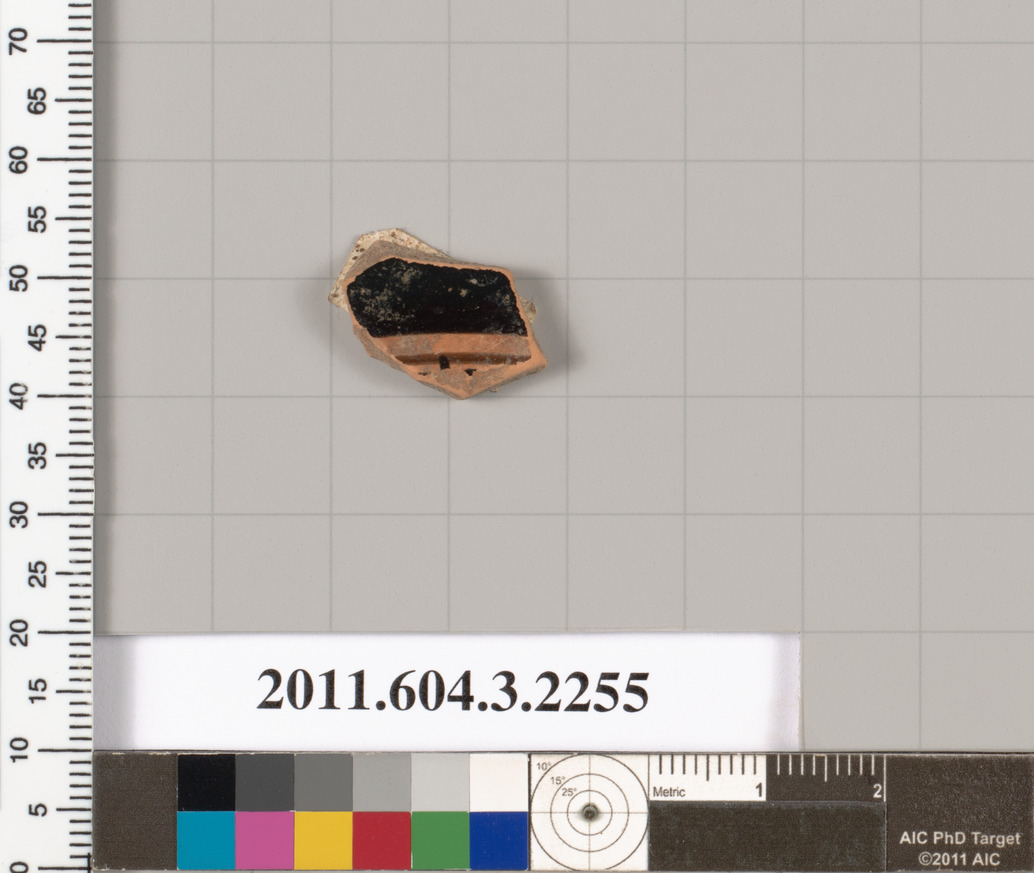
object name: kylix fragment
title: Terracotta fragment of a kylix (drinking cup)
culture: greek, attic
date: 600-401 BCE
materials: terracotta